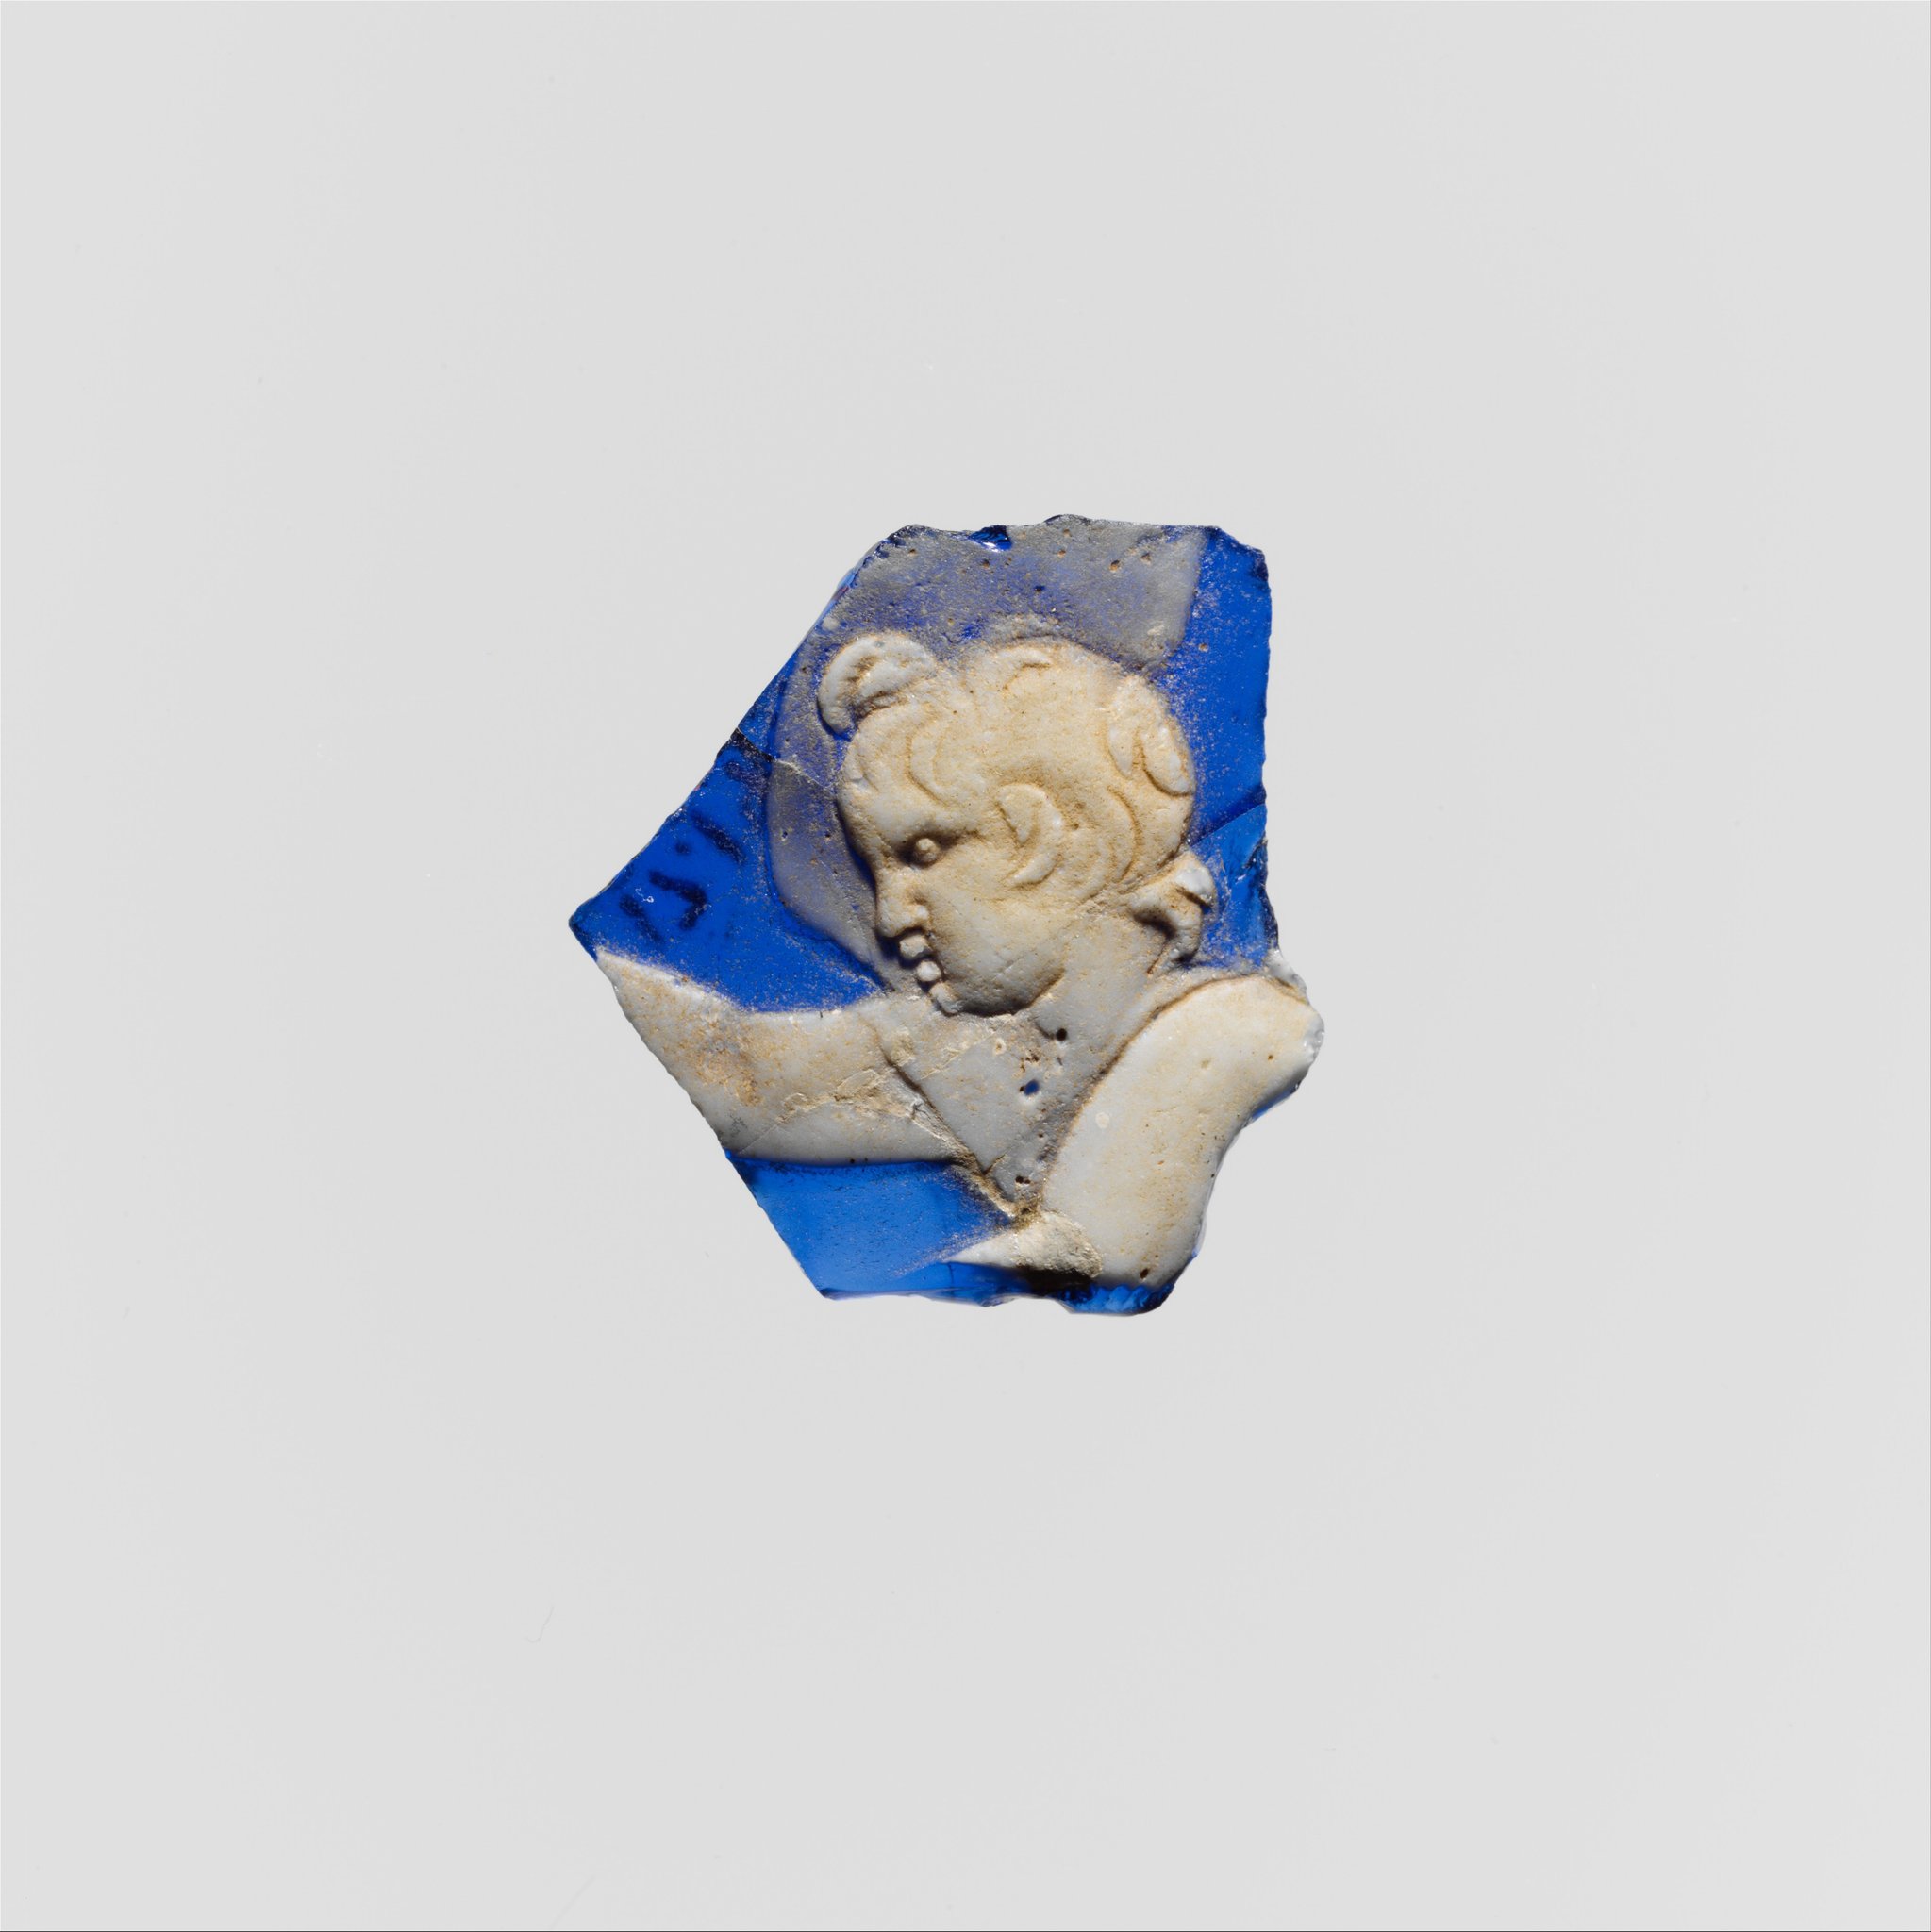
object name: cameo, fragment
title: Glass cameo fragment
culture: roman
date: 67-100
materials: glass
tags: cupid